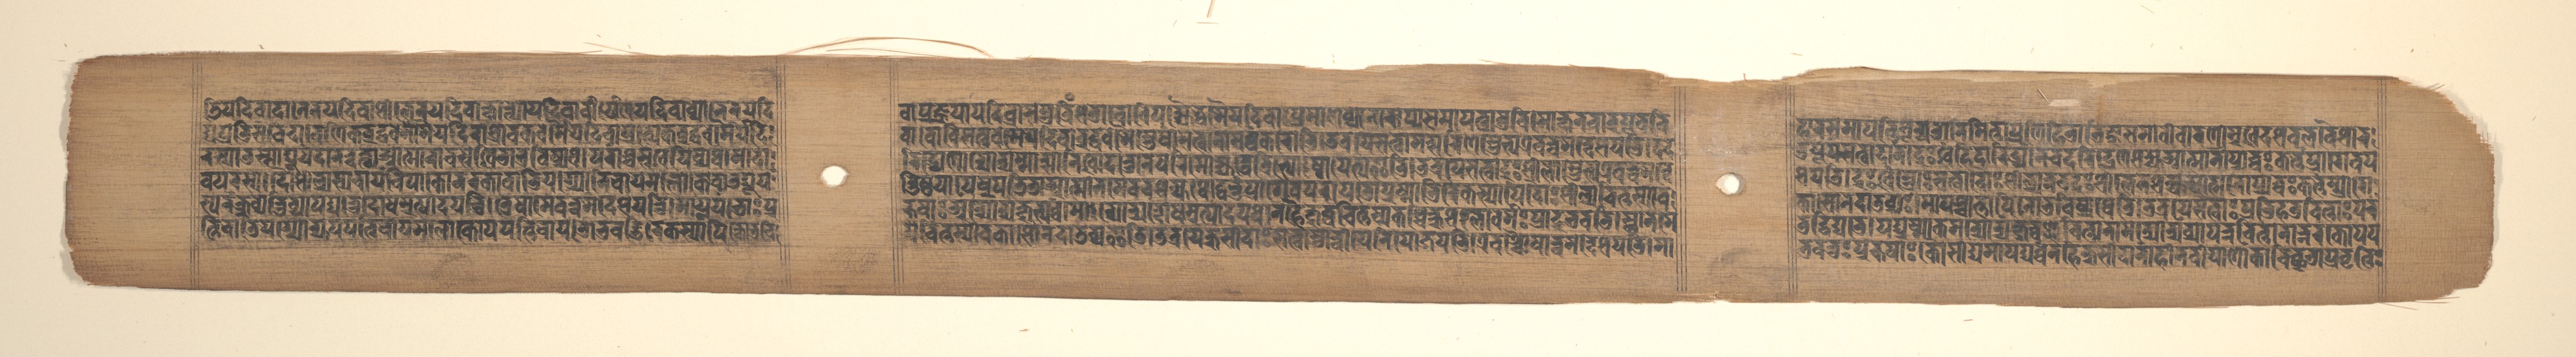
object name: folio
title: Folio from a Buddhist Manuscript of Pancavimsatisahasrika Prajnaparamita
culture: indian, bengal or bangladesh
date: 1090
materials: leaf, watercolor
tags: buddhism